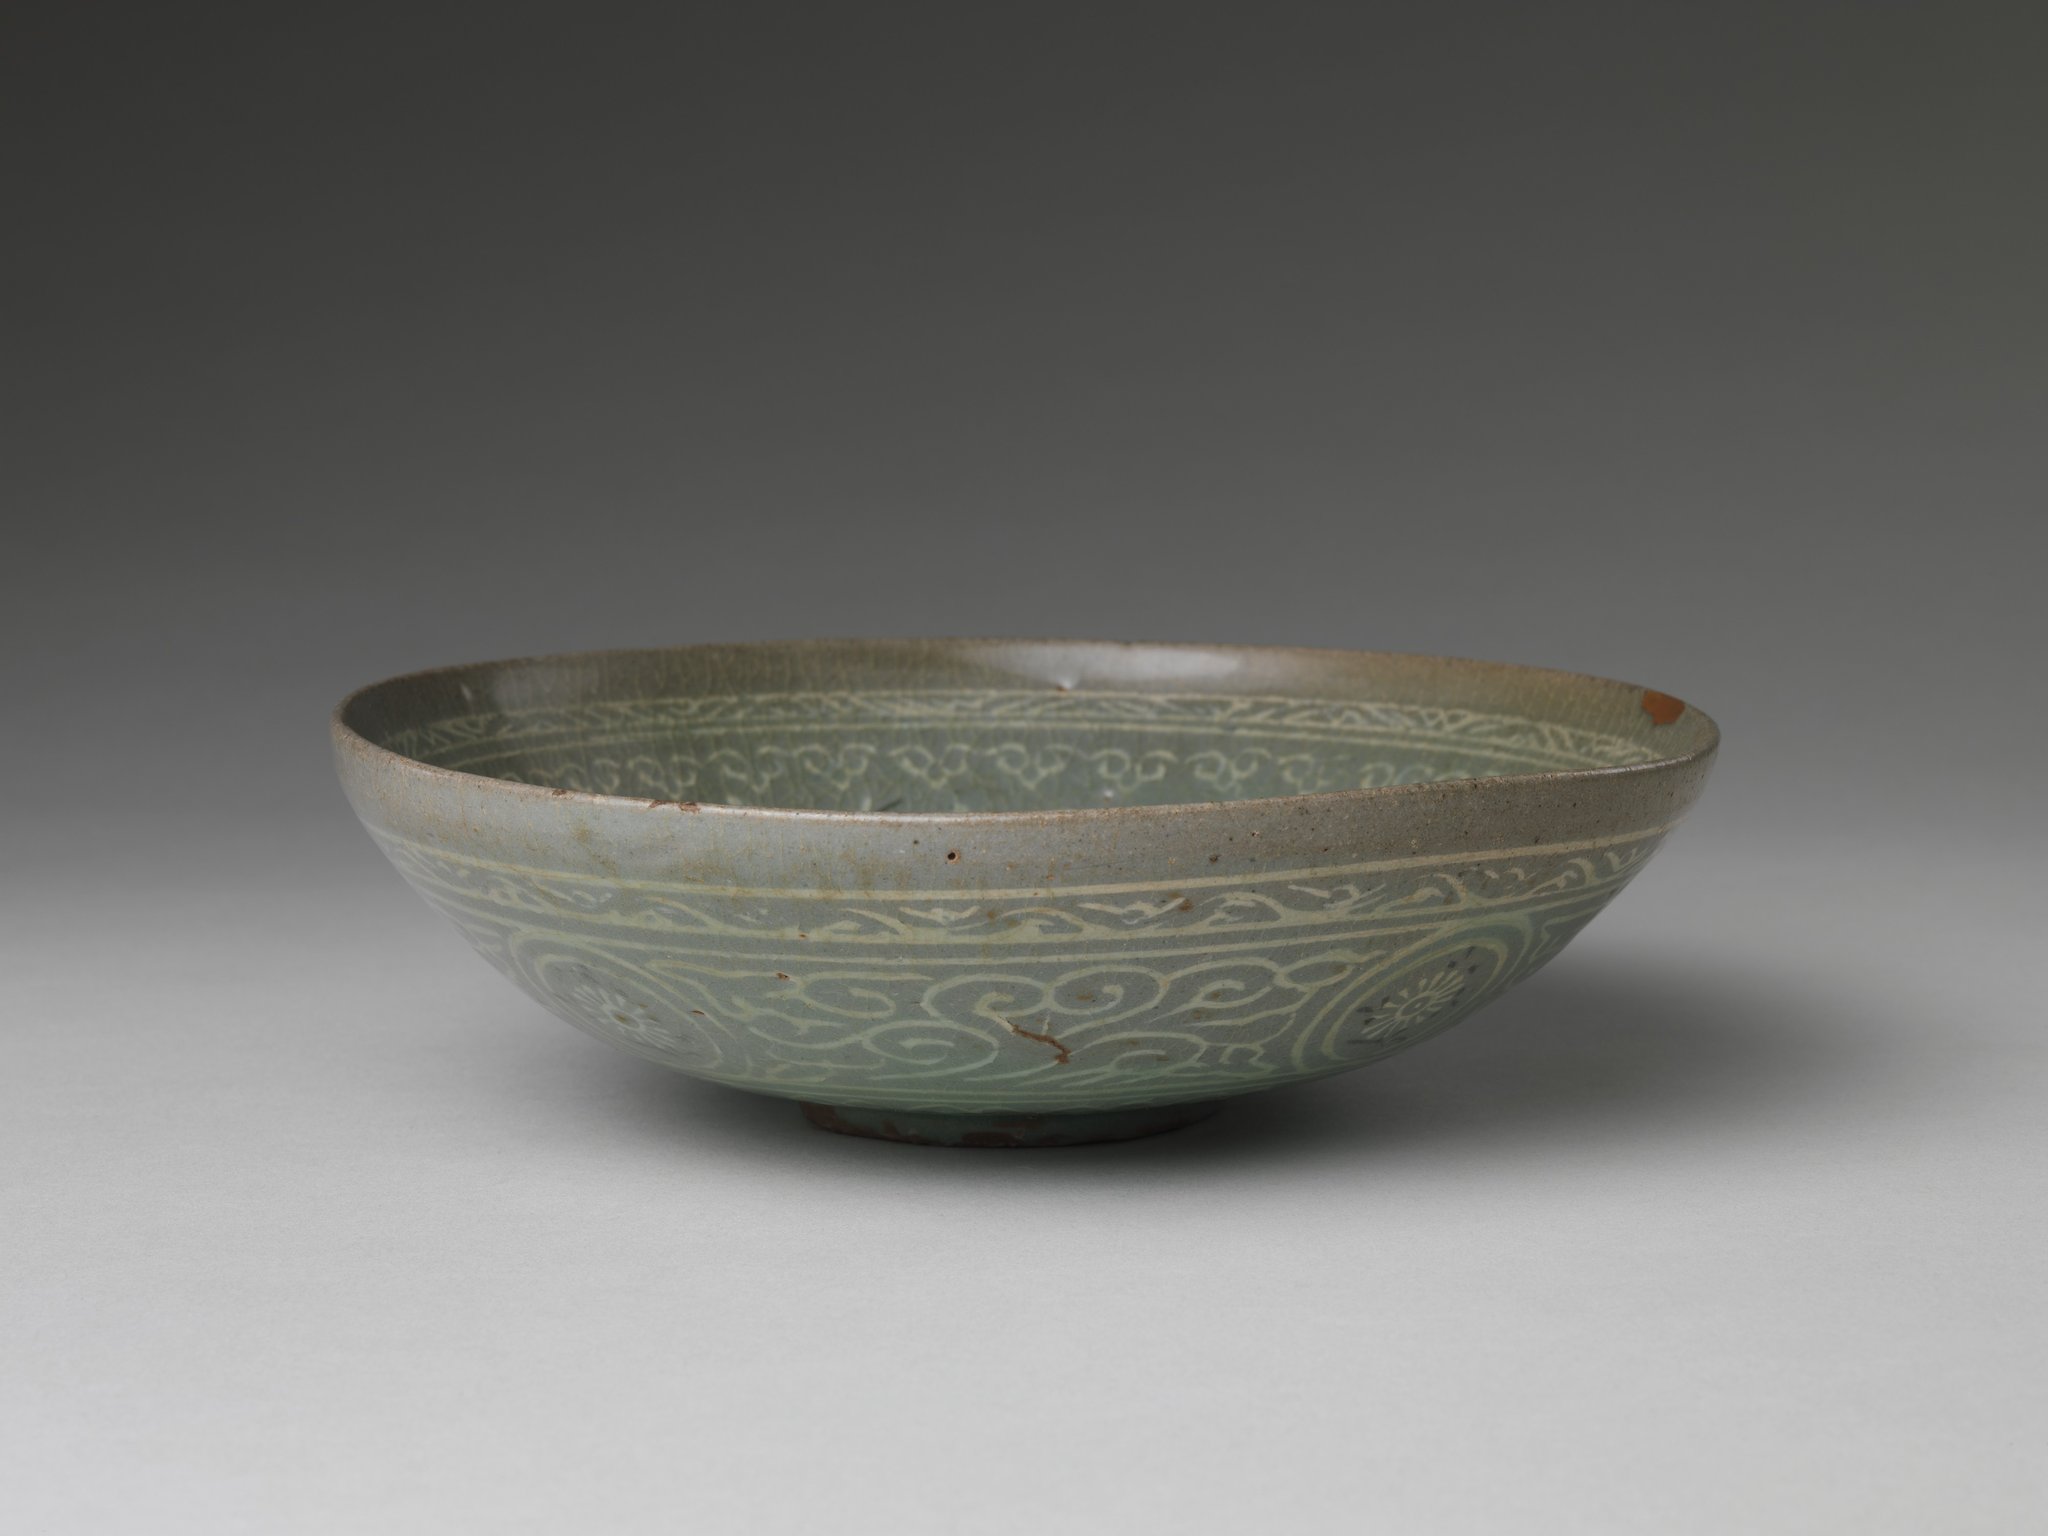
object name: bowl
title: Bowl decorated with phoenixes and clouds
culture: korean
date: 1301-1333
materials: ceramic glaze, glaze, stoneware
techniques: inlay